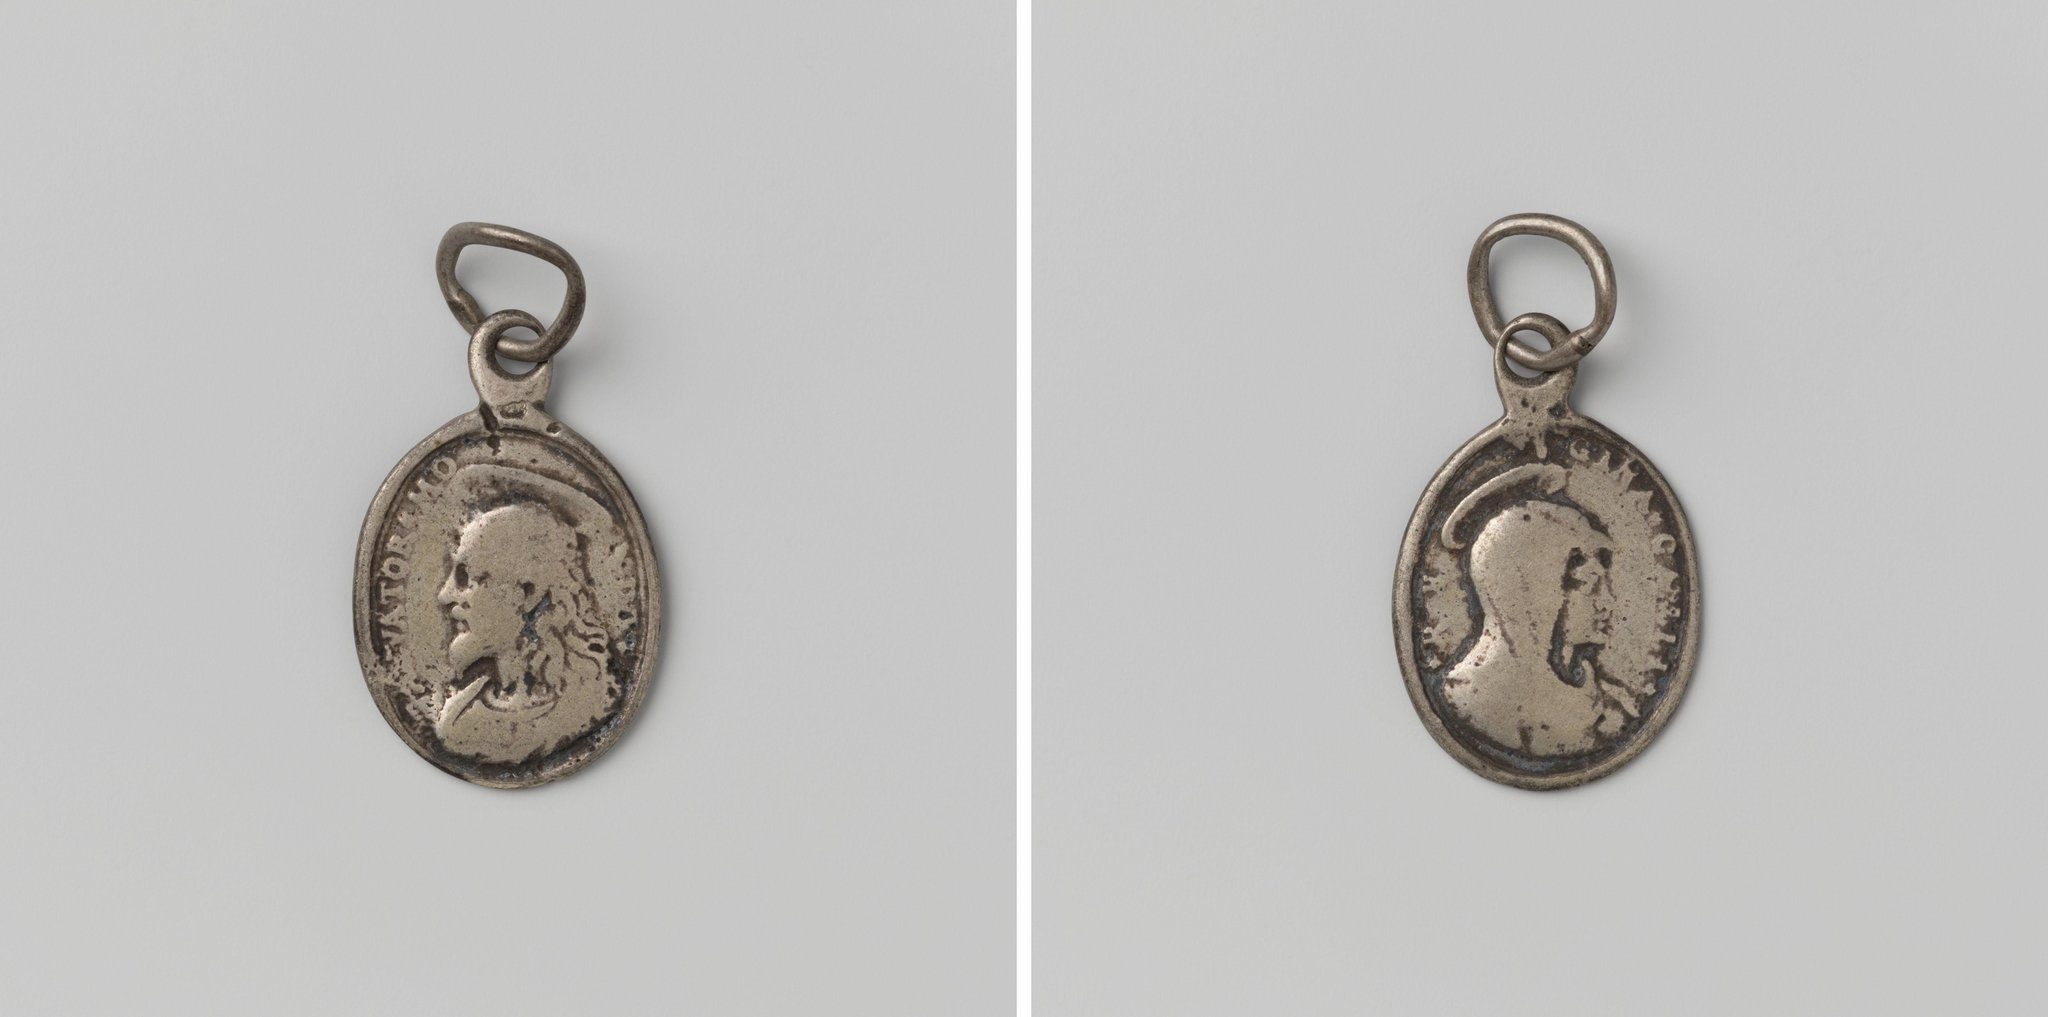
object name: devotional medal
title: Christus en Maria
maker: Anonymous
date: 1600-1850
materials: silver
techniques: casting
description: Zilveren ovale penning aan draagoog en draagring. Voorzijde: naar links gewende Christus met aureool binnen omschrift. Keerzijde: naar rechts gewende, gesluierde Maria binnen omschrift